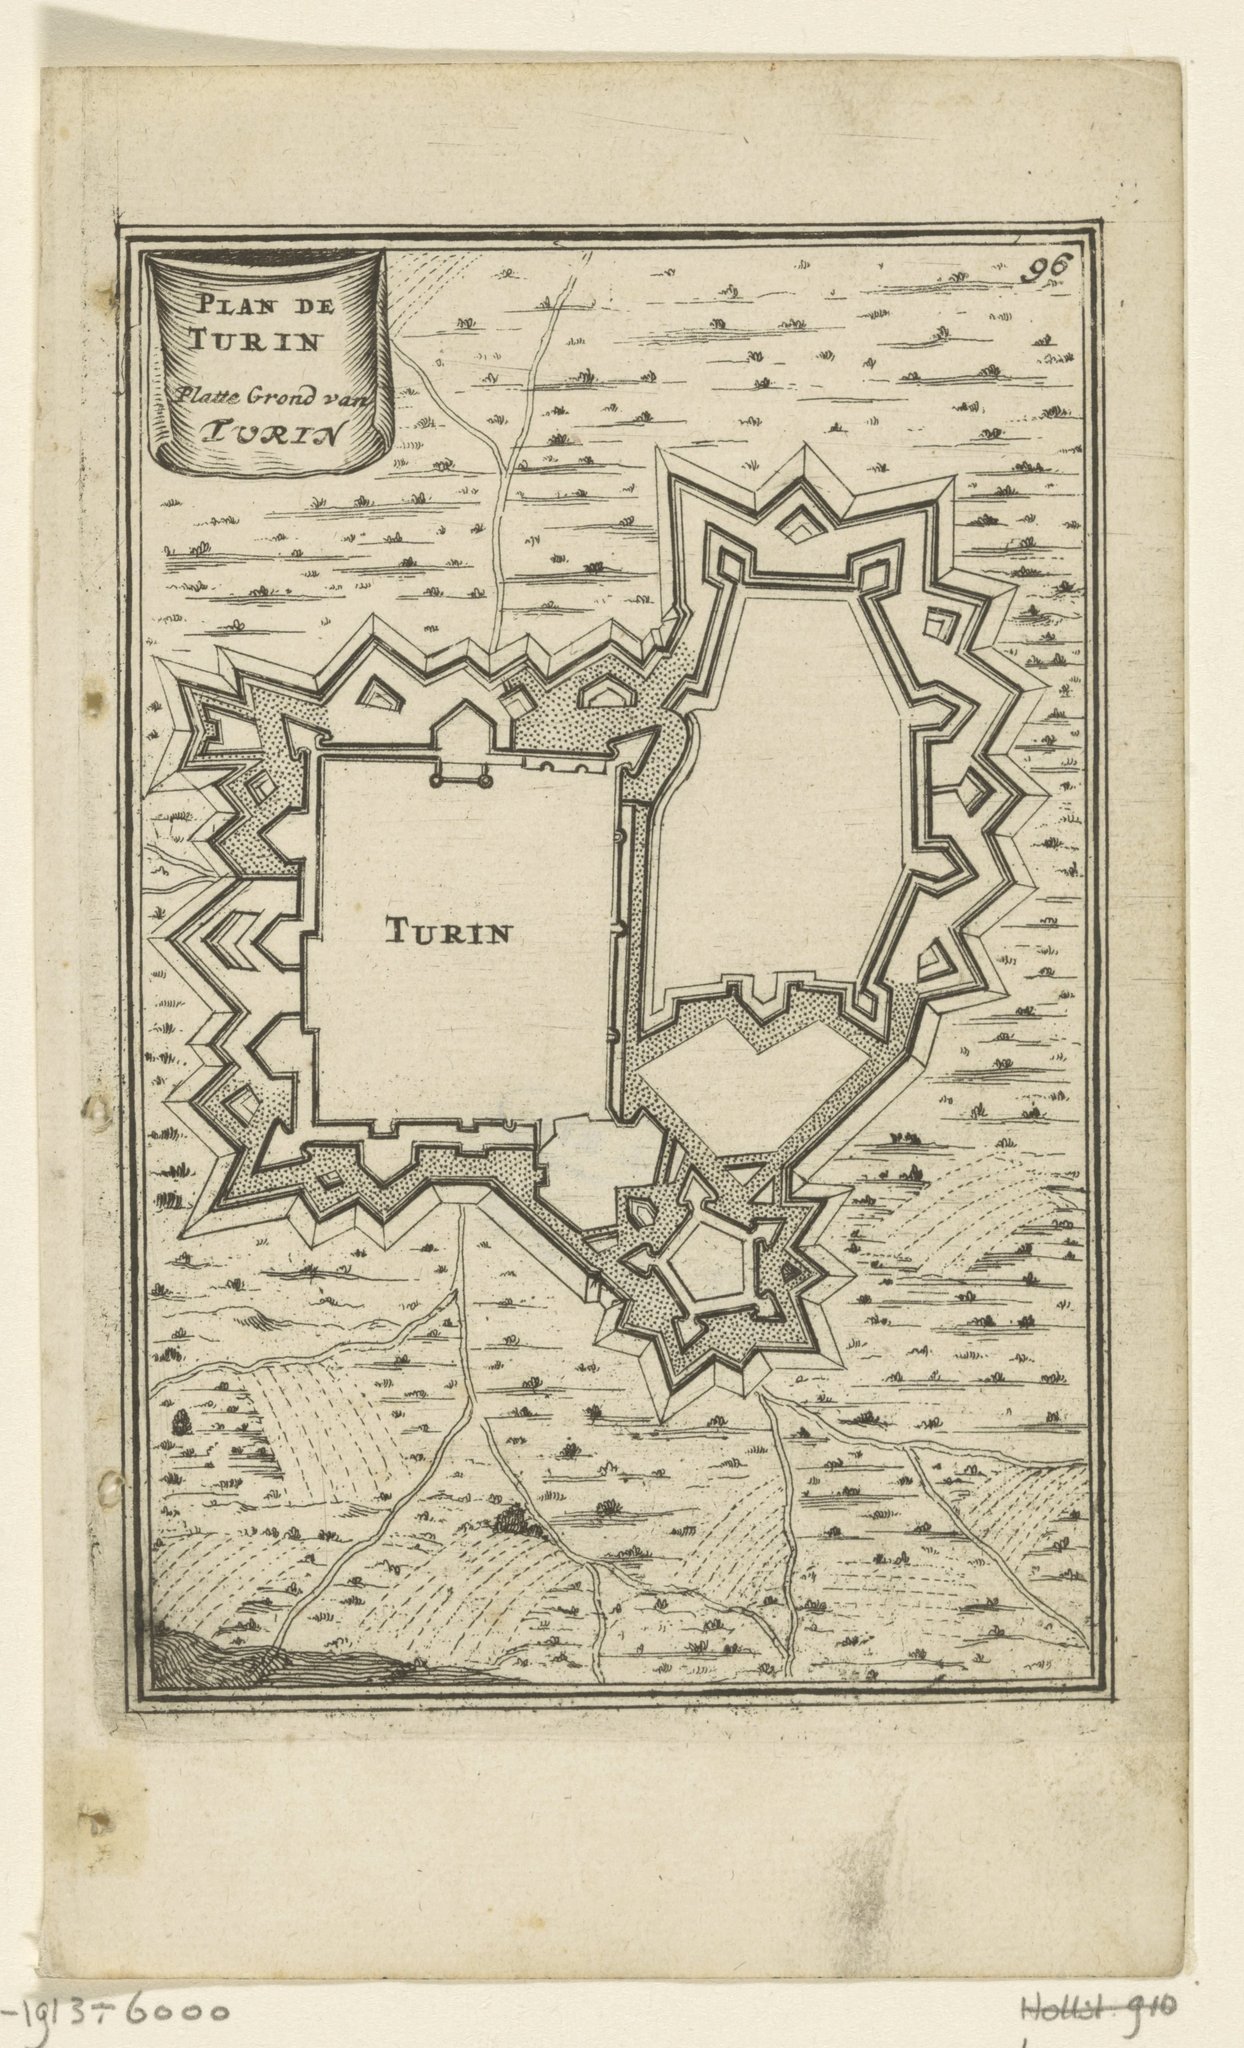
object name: print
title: Illustratie voor 'Den Arbeid van Mars' van Allain Manesson Mallet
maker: romeyn de hooghe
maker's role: draughtsman, goldsmith, painter, print maker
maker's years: 1645-1708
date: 1672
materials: paper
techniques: engraving, etching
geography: amsterdam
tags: city-view in general; 'veduta', fortifications, military engineering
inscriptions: collector's mark: Lugt 2228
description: Illustratie voor: Allain Manesson Mallet, 'Den Arbeid van Mars' (3 delen, Amsterdam: Jacob van Meurs of Amsterdam: Jacob van Meurs en Johannes (I) Janssonius van Waesberge, 1672). Klinkert, C.